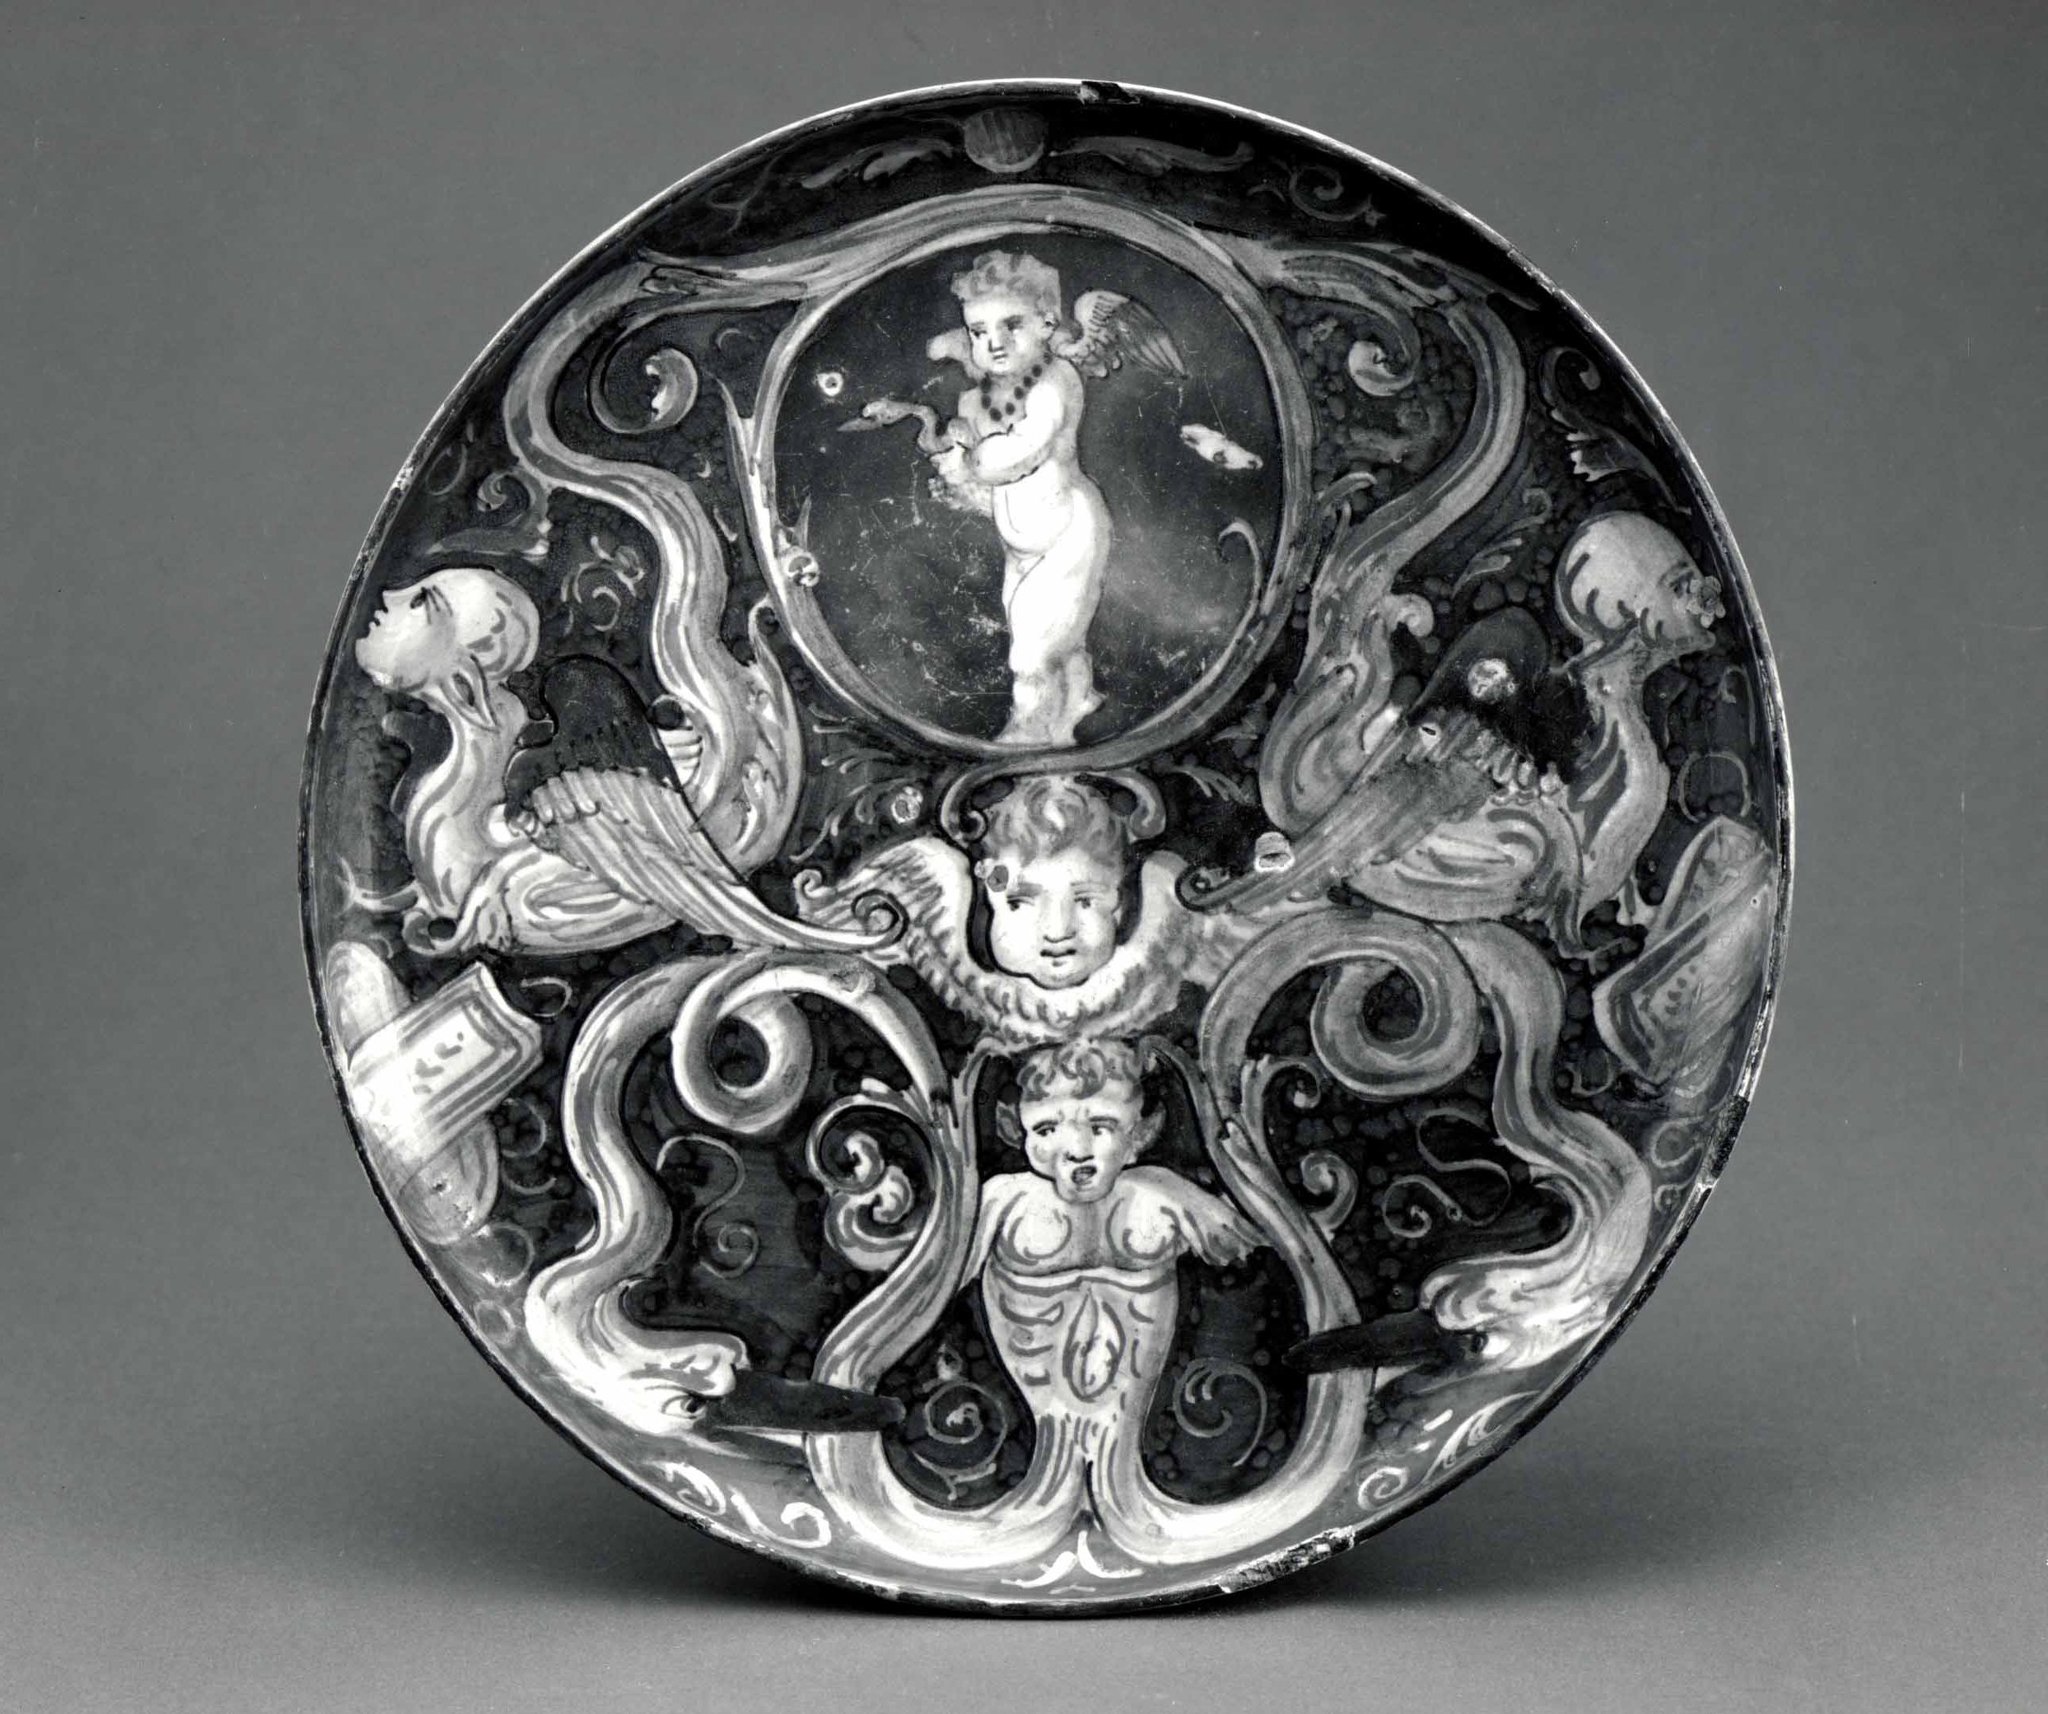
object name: dish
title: Dish (coppa)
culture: italian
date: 1530-1535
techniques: maiolica, glazing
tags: cupid